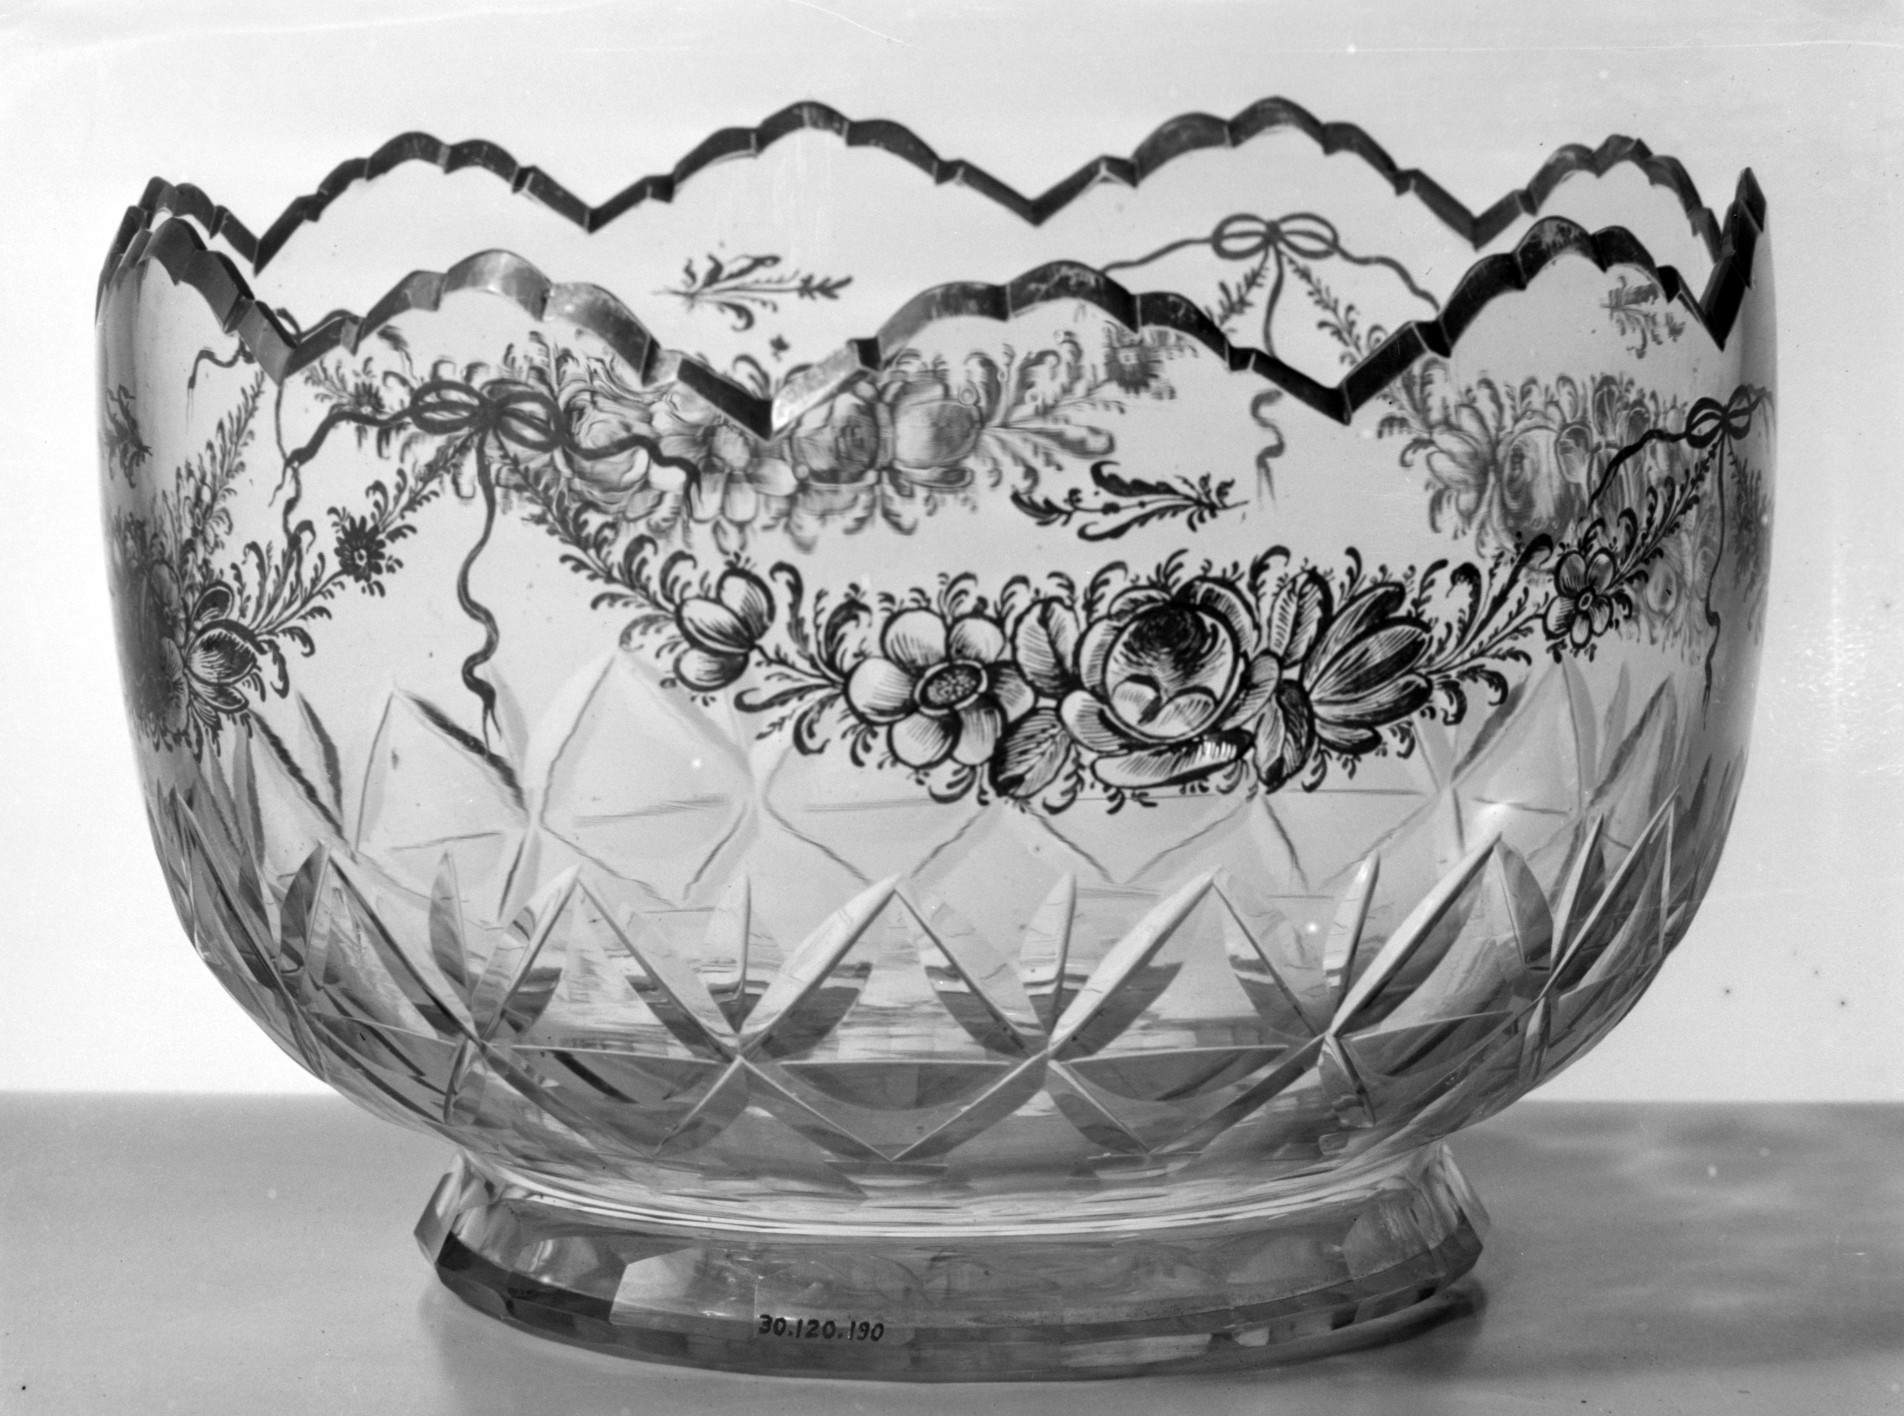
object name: bowl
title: Bowl (one of a pair)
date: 1801-1833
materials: glass